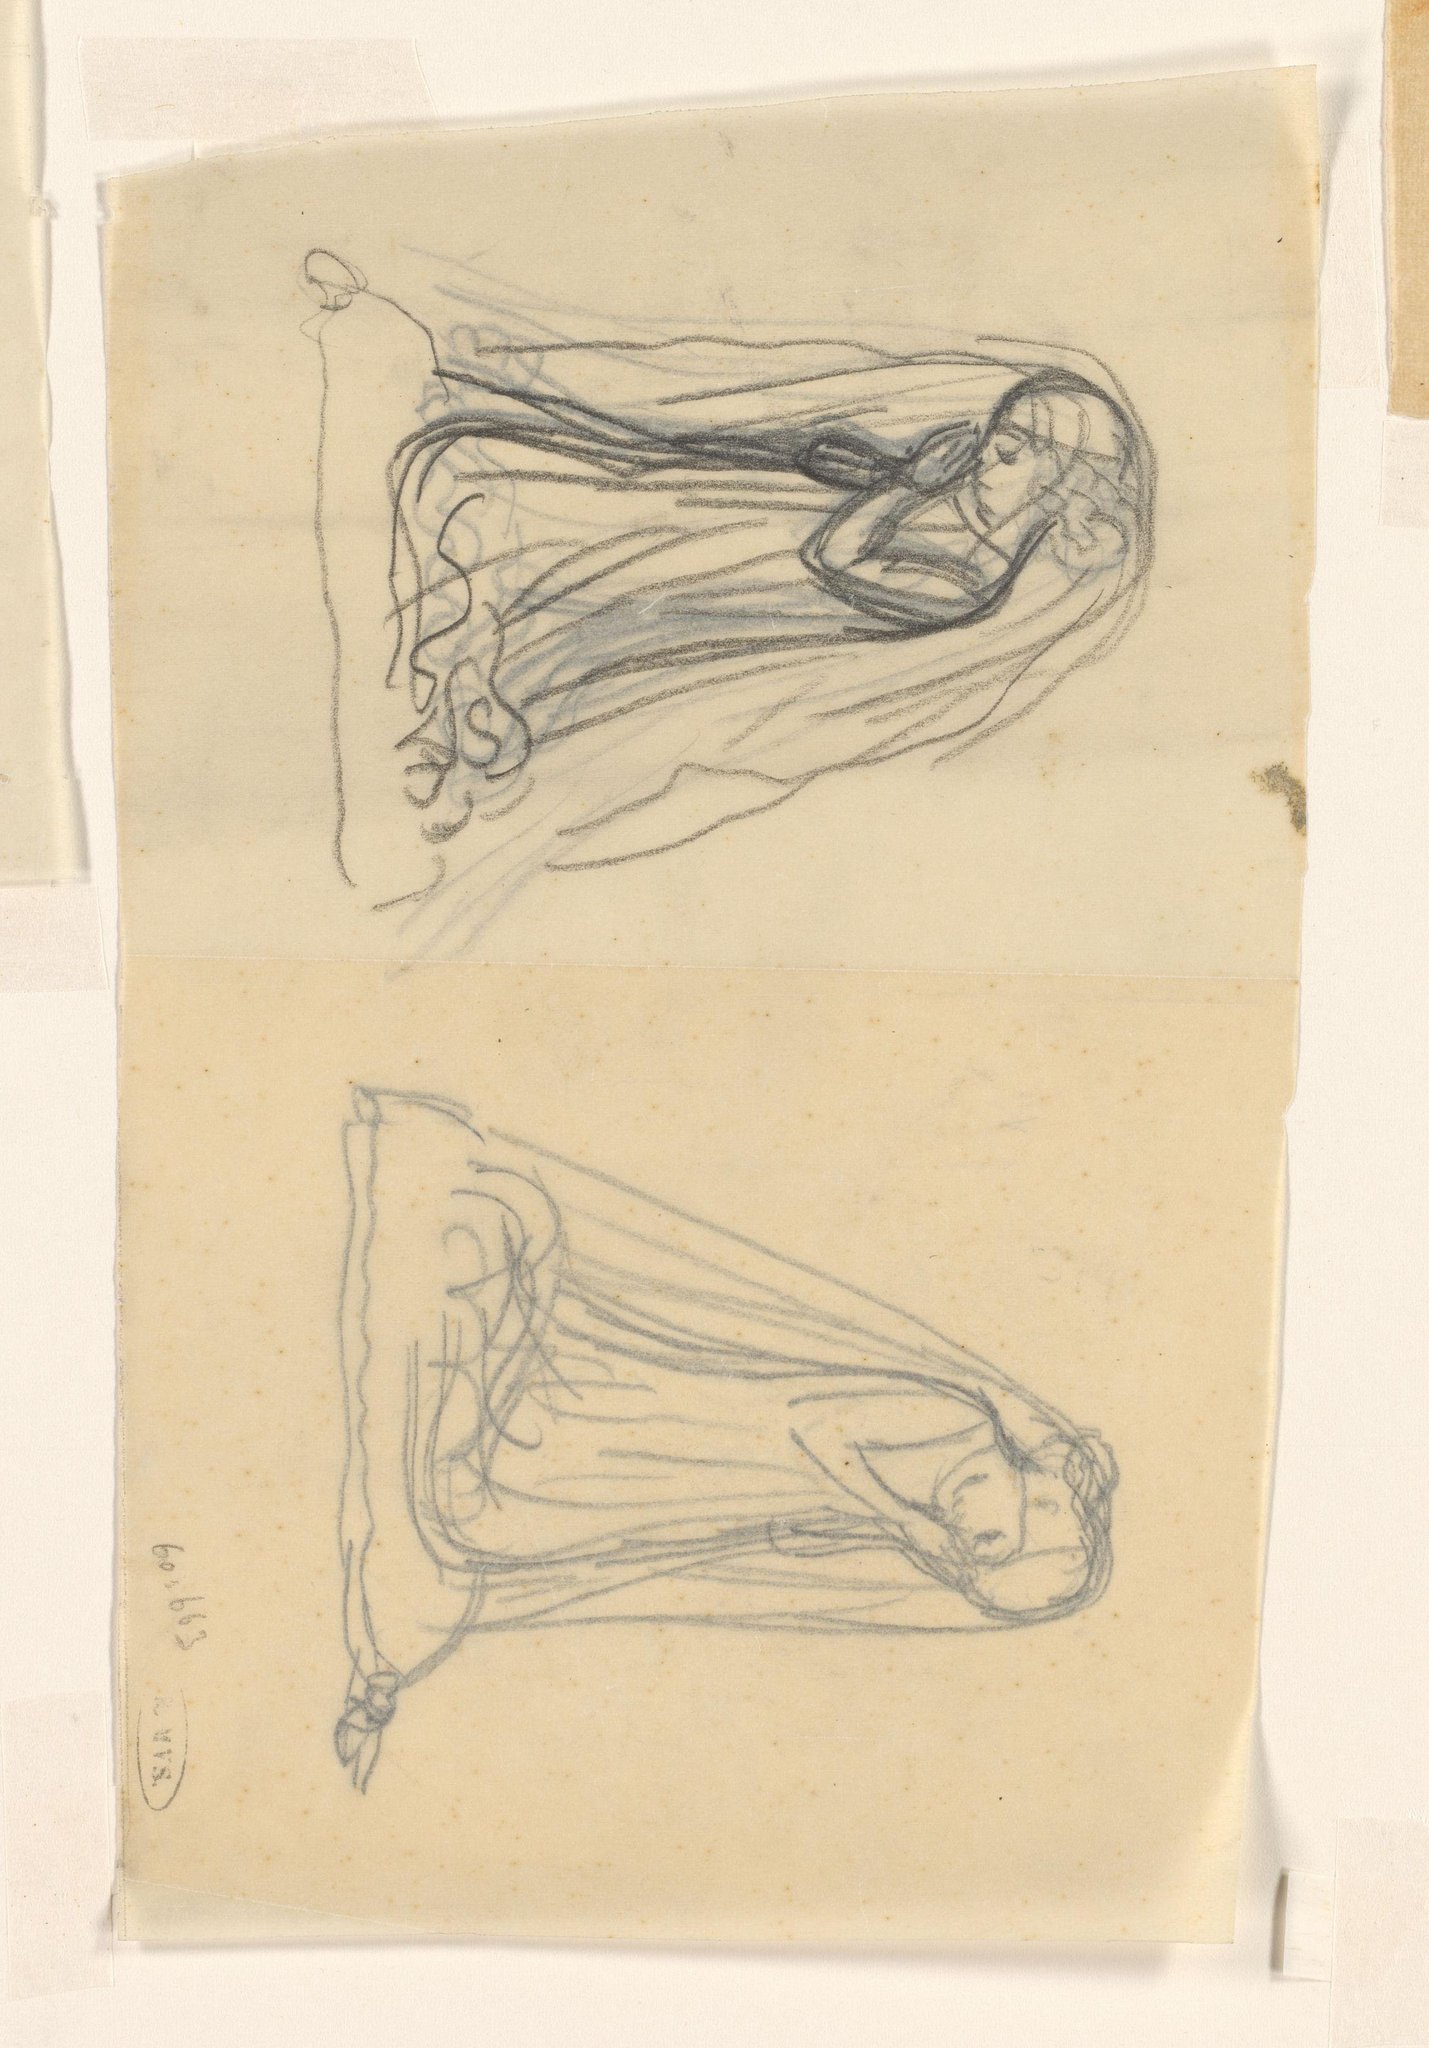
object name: drawing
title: Biddend meisje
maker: leo gestel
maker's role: draughtsman, print maker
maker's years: 1881-1941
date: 1930-1935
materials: pencil, paper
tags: girl (child between toddler and youth), kneeling figure, holy communion ~ protestant service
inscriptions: collector's mark: Lugt 2228